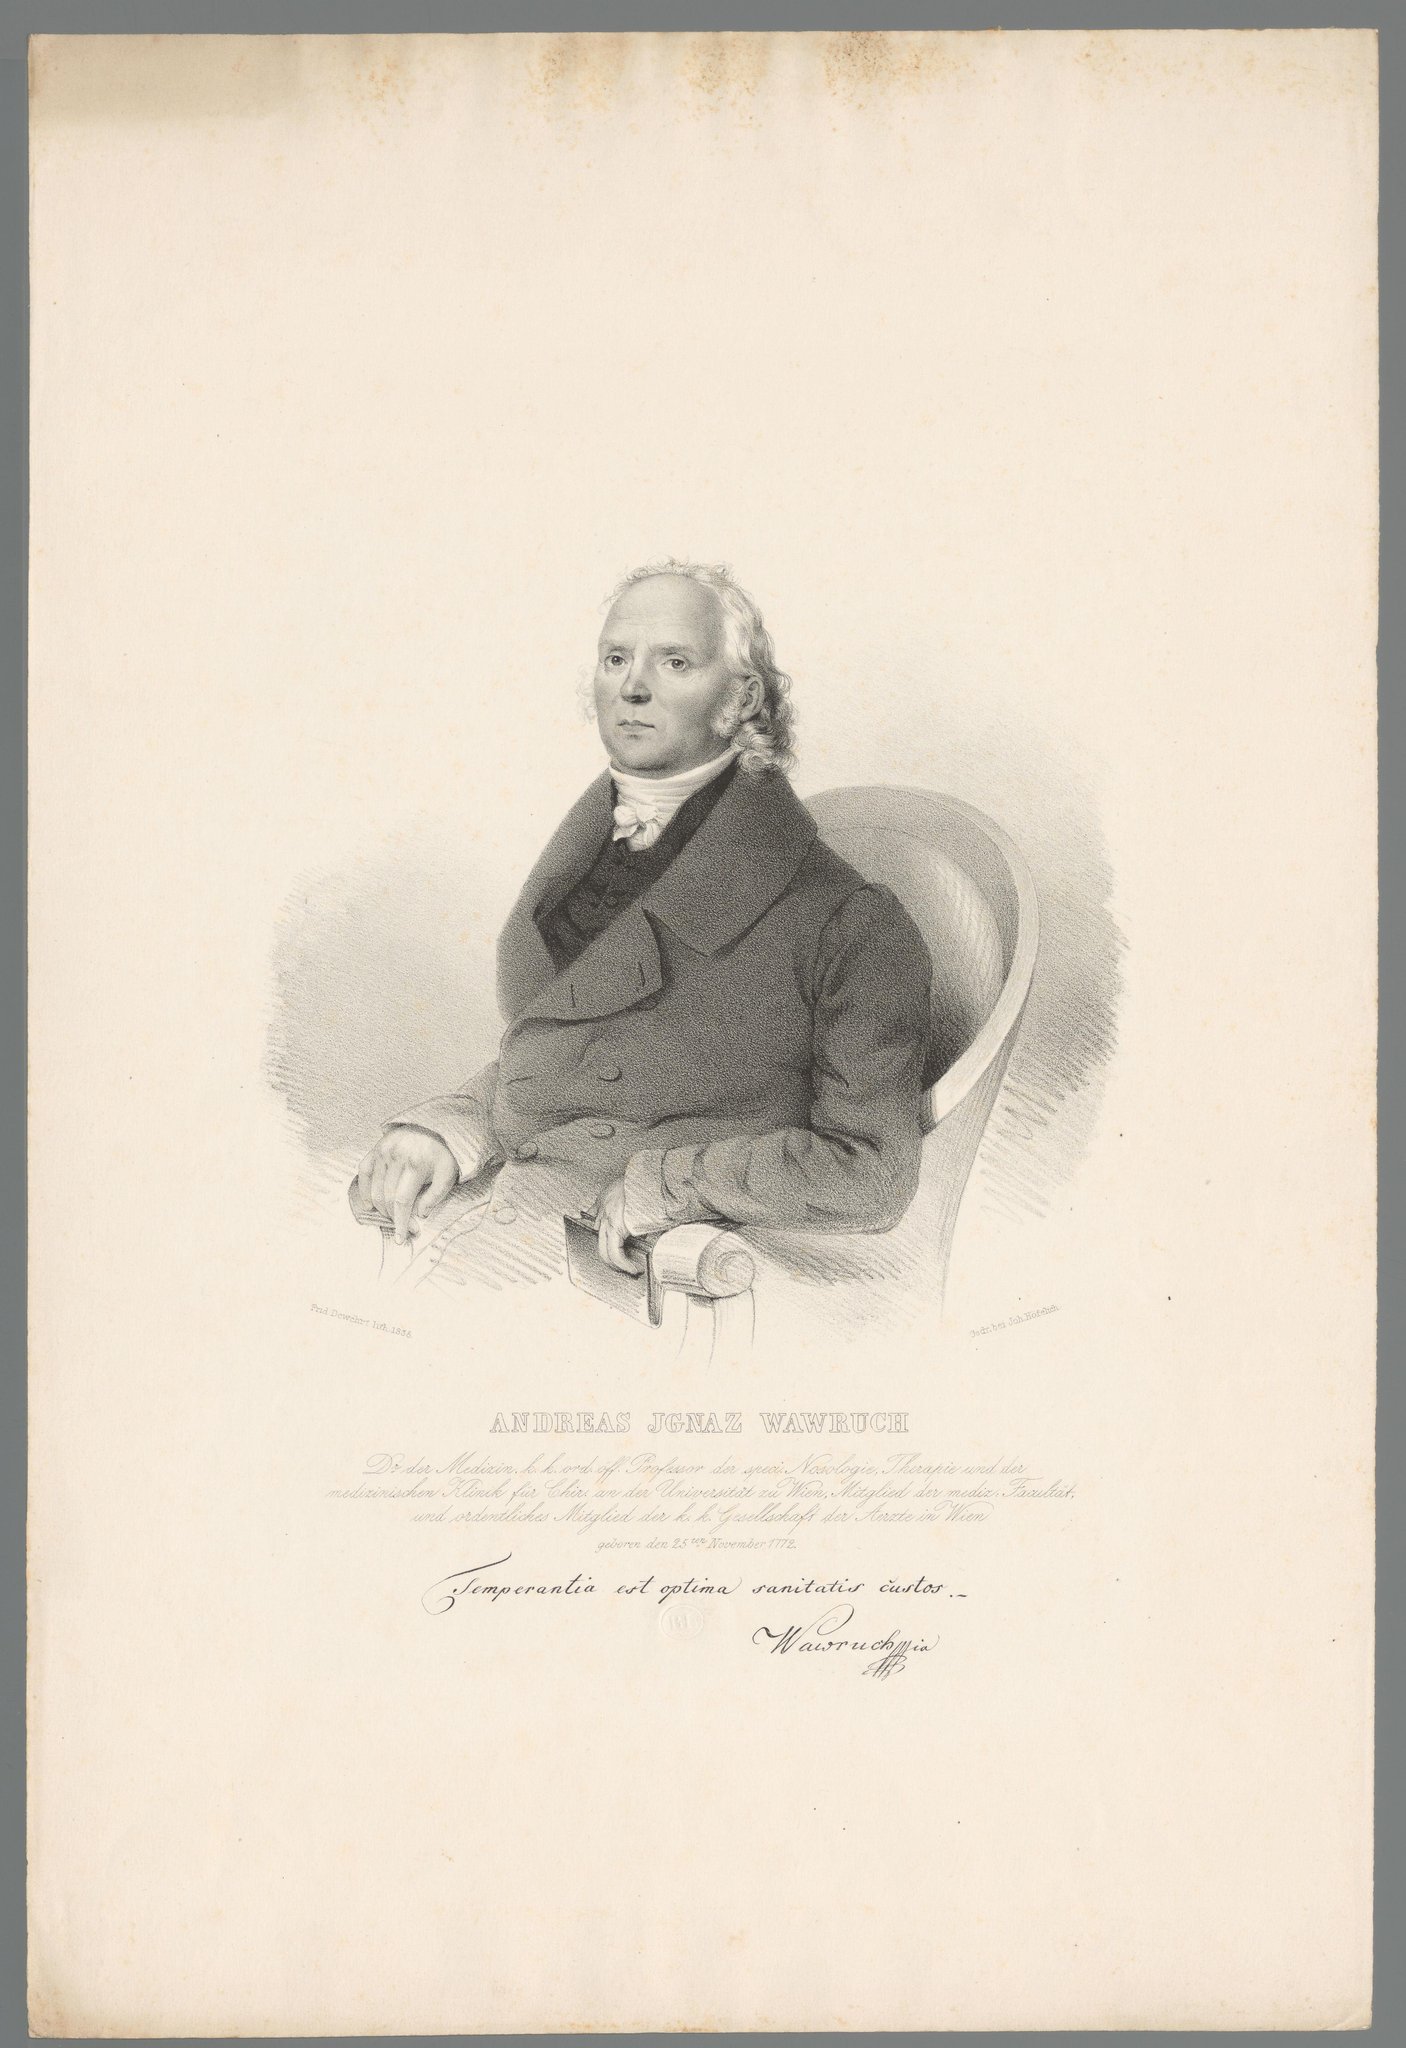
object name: print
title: Portret van Andreas Ignaz Wawruch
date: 1835-1848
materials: paper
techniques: lithograph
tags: historical persons, physician, doctor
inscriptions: collector's mark: Lugt 2228